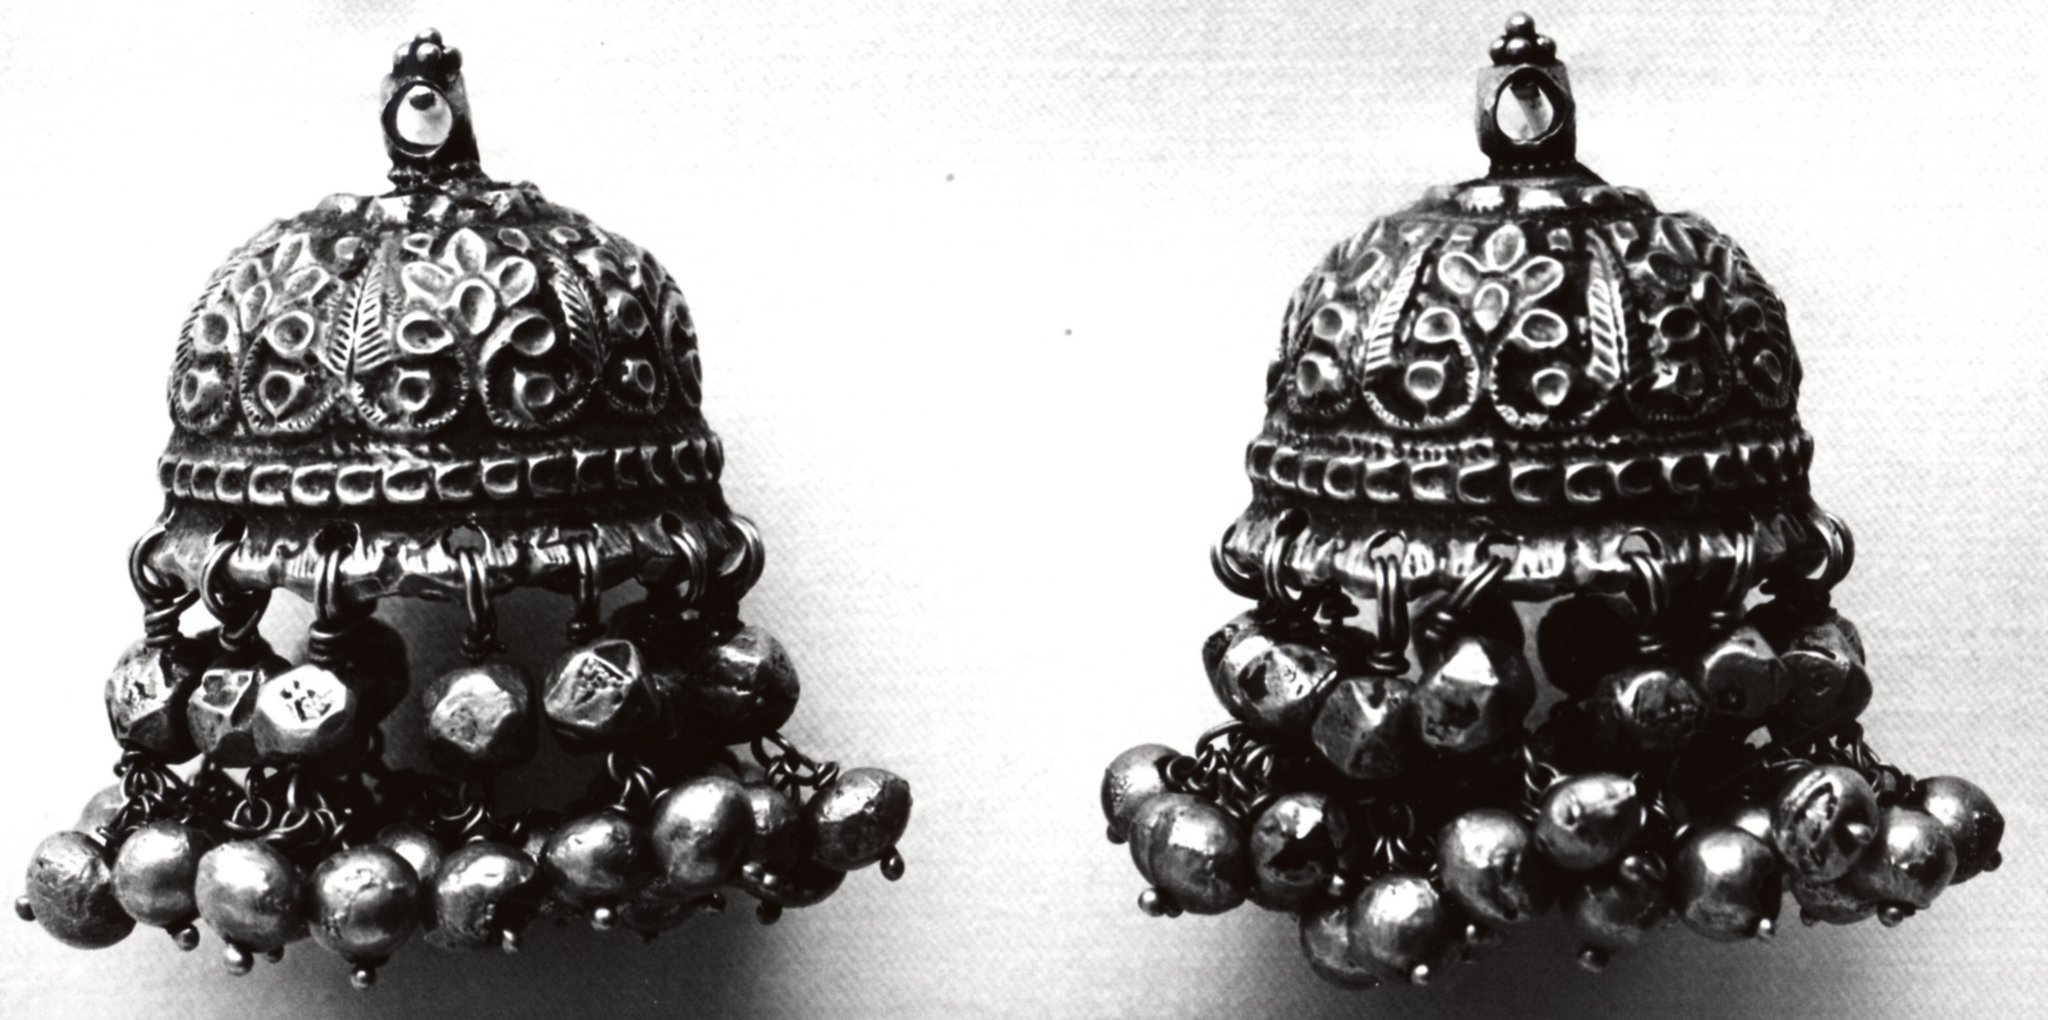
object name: pendant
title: Pendant (Jkumka), One of a Pair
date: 1801-1900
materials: gold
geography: northern india